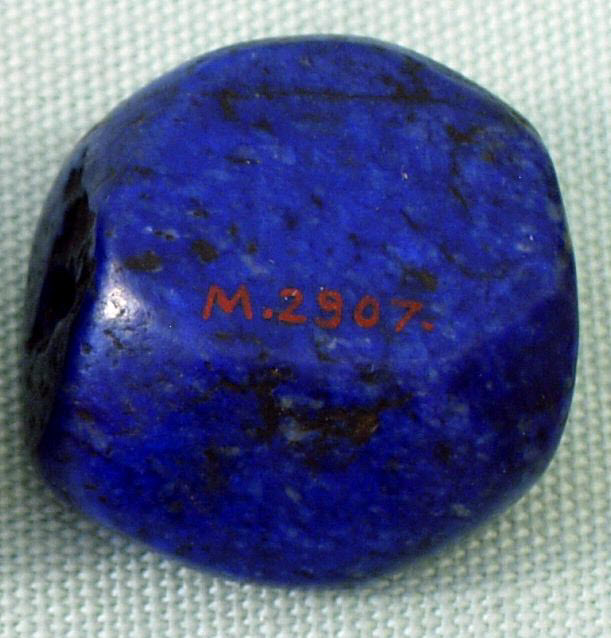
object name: bead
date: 801-1900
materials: lapis lazuli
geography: egypt